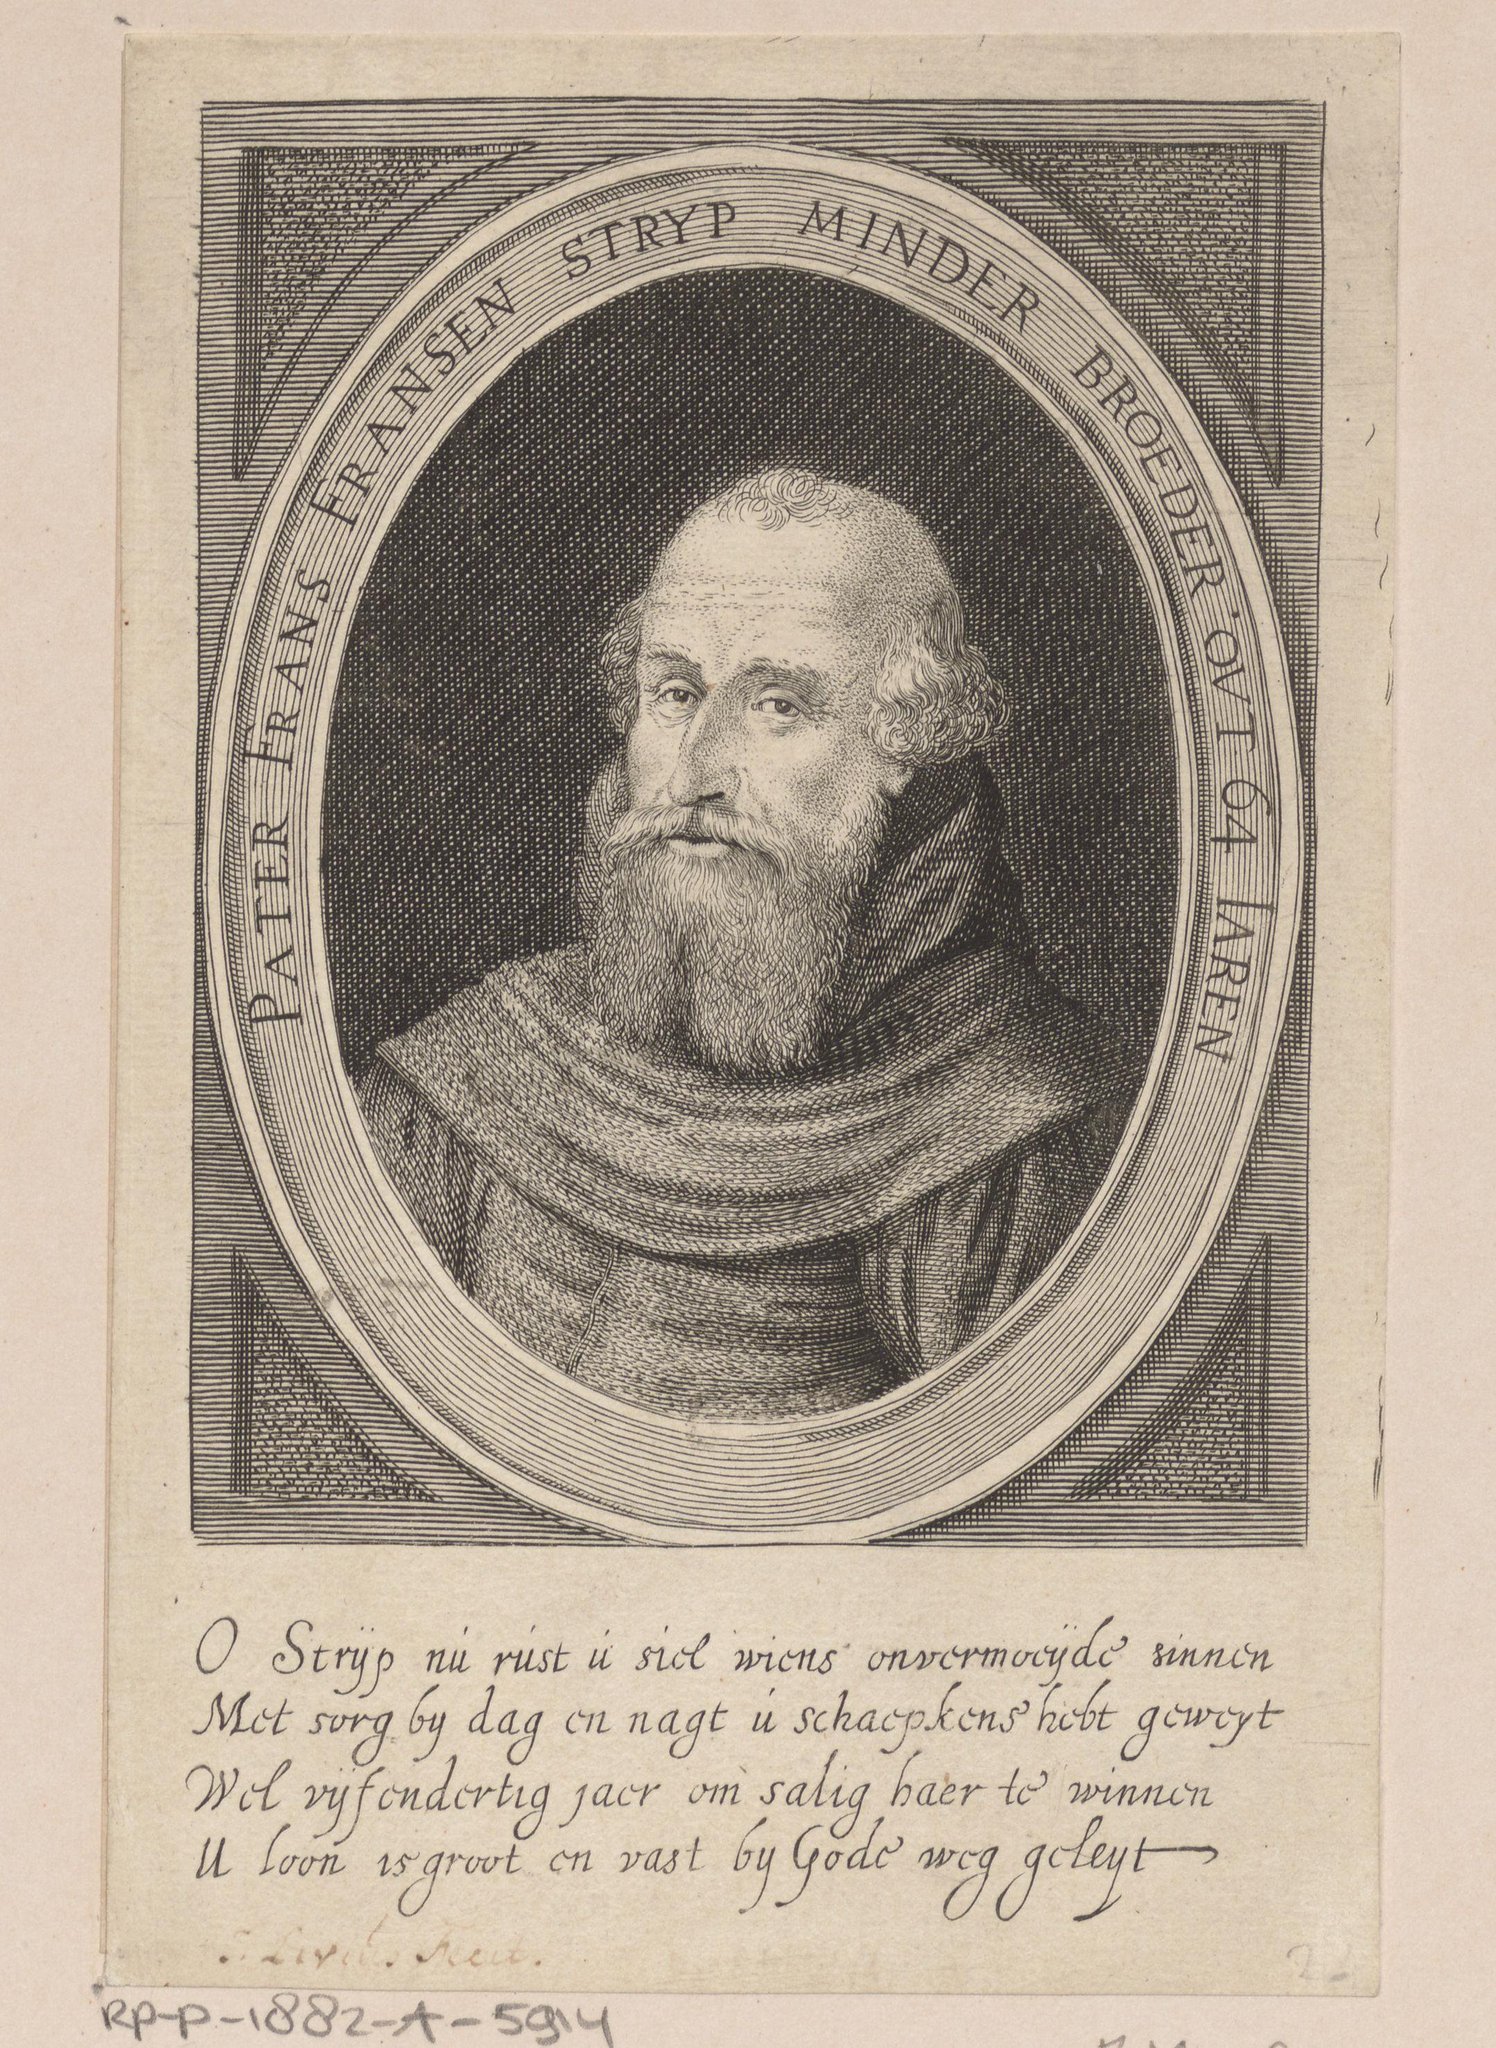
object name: print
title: Portret van Franciscus Strijp op 64-jarige leeftijd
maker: philip fruytiers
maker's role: print maker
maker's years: 1610-1666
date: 1620-1666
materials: paper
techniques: engraving, etching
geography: antwerp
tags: historical persons, monk(s), friar(s)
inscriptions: collector's mark: Lugt 2228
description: Met onder het portret een vierregelig vers in het Nederlands.